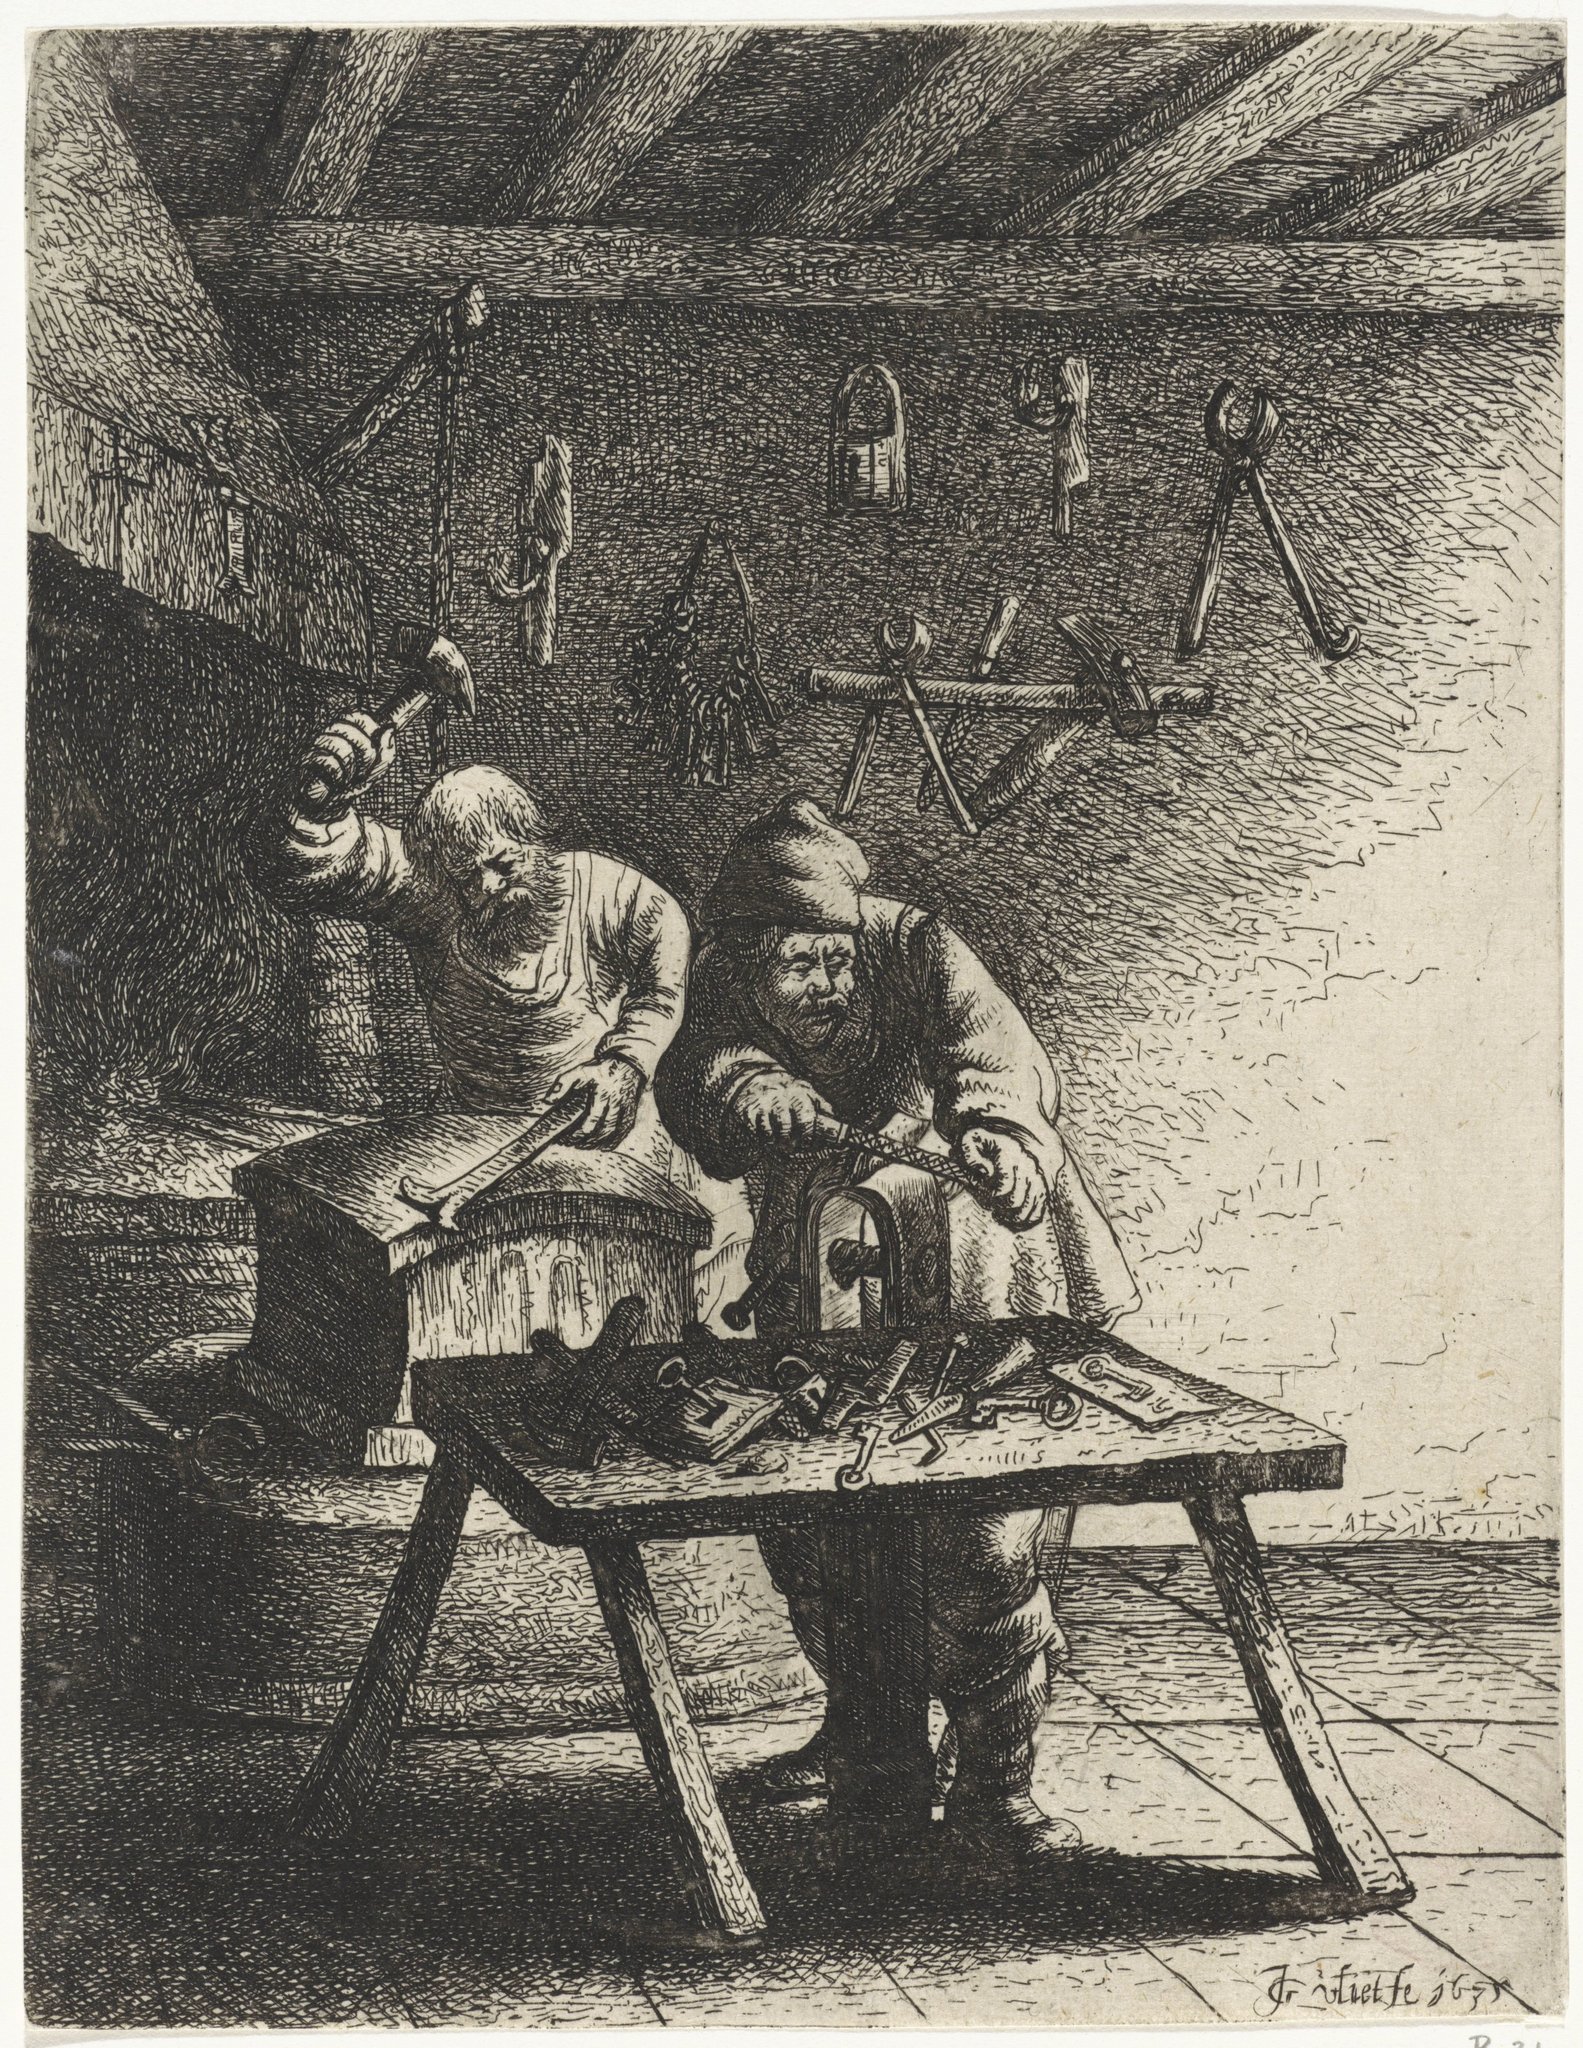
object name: print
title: Beroepen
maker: jan gillisz. van vliet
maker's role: draughtsman, painter, print maker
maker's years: 1600-1668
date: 1635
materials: paper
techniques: etching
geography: leiden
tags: tools, aids, implements ~ crafts and industries: tongs, tools, aids, implements ~ crafts and industries: file, lock-smith, tools, aids, implements ~ crafts and industries: hammer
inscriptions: collector's mark: Lugt 240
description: Twee slotenmakers aan het werk in een werkplaats.